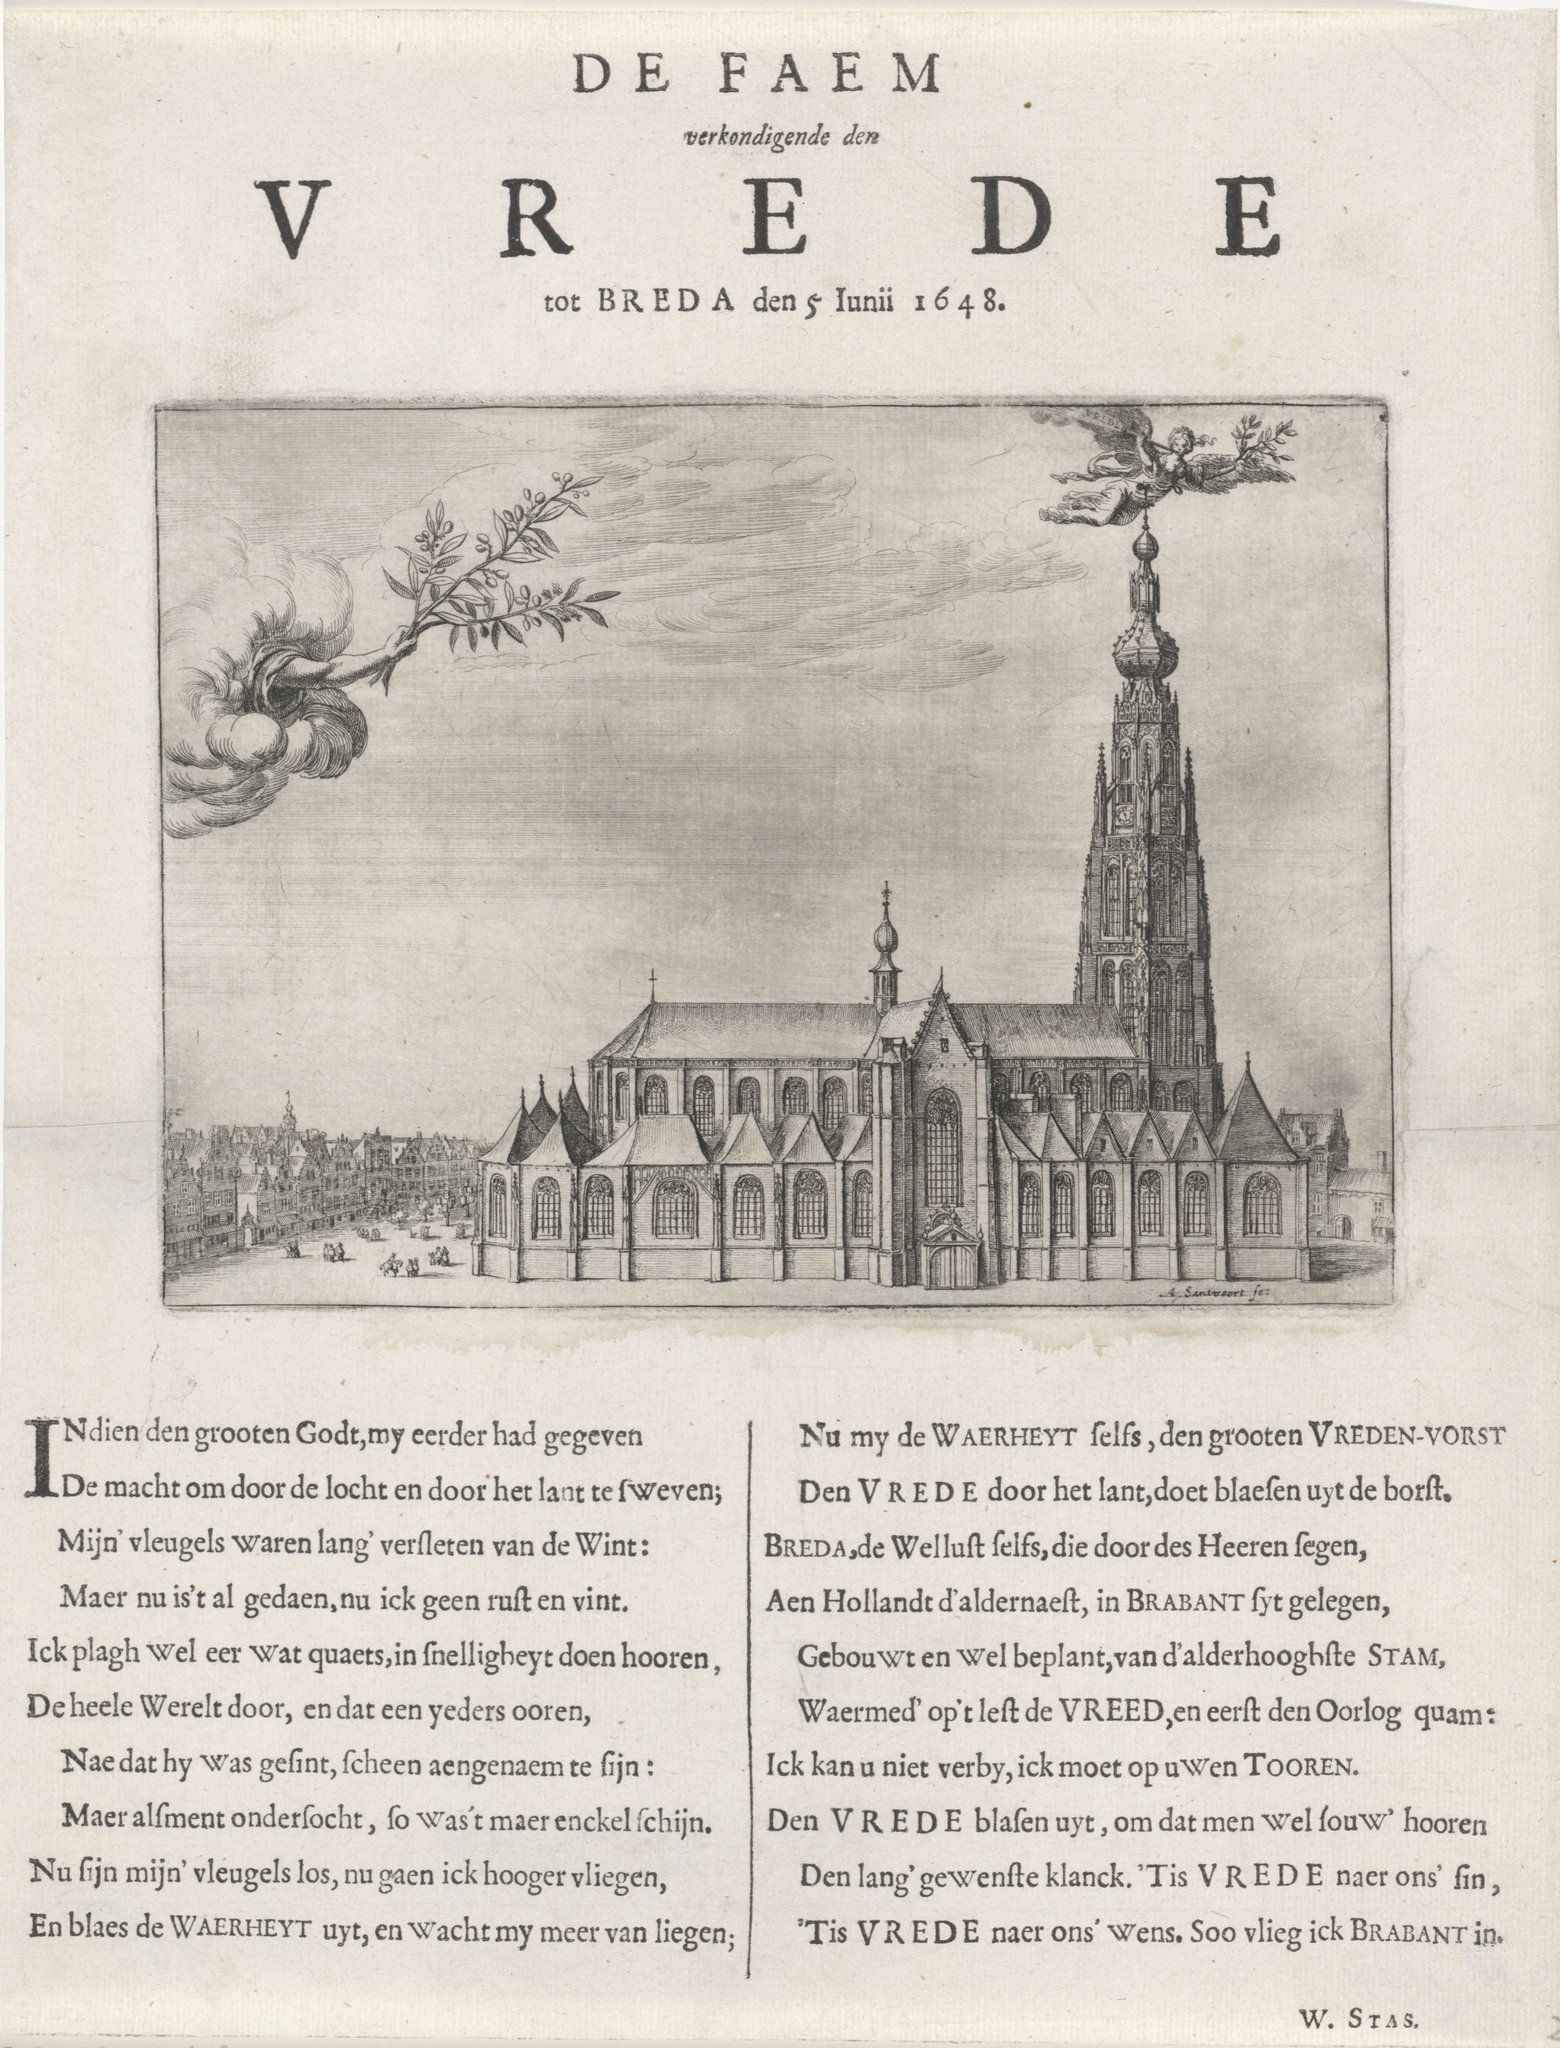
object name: print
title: De Faem verkondigende den vrede tot Breda den 5 Iunii 1648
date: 1648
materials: paper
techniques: etching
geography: netherlands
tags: fama as roman personification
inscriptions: collector's mark: Lugt 2228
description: Faam vliegt met een olijftak langs de torenspits van de Grote Kerk te Breda. Ze blaast het woord vrede op haar bazuin. Links steekt de hand van God met lauriertakken uit een wolk. Naast de kerk enkele huizen en figuren. Onder de voorstelling een twintigregelig gedicht in het Nederlands.